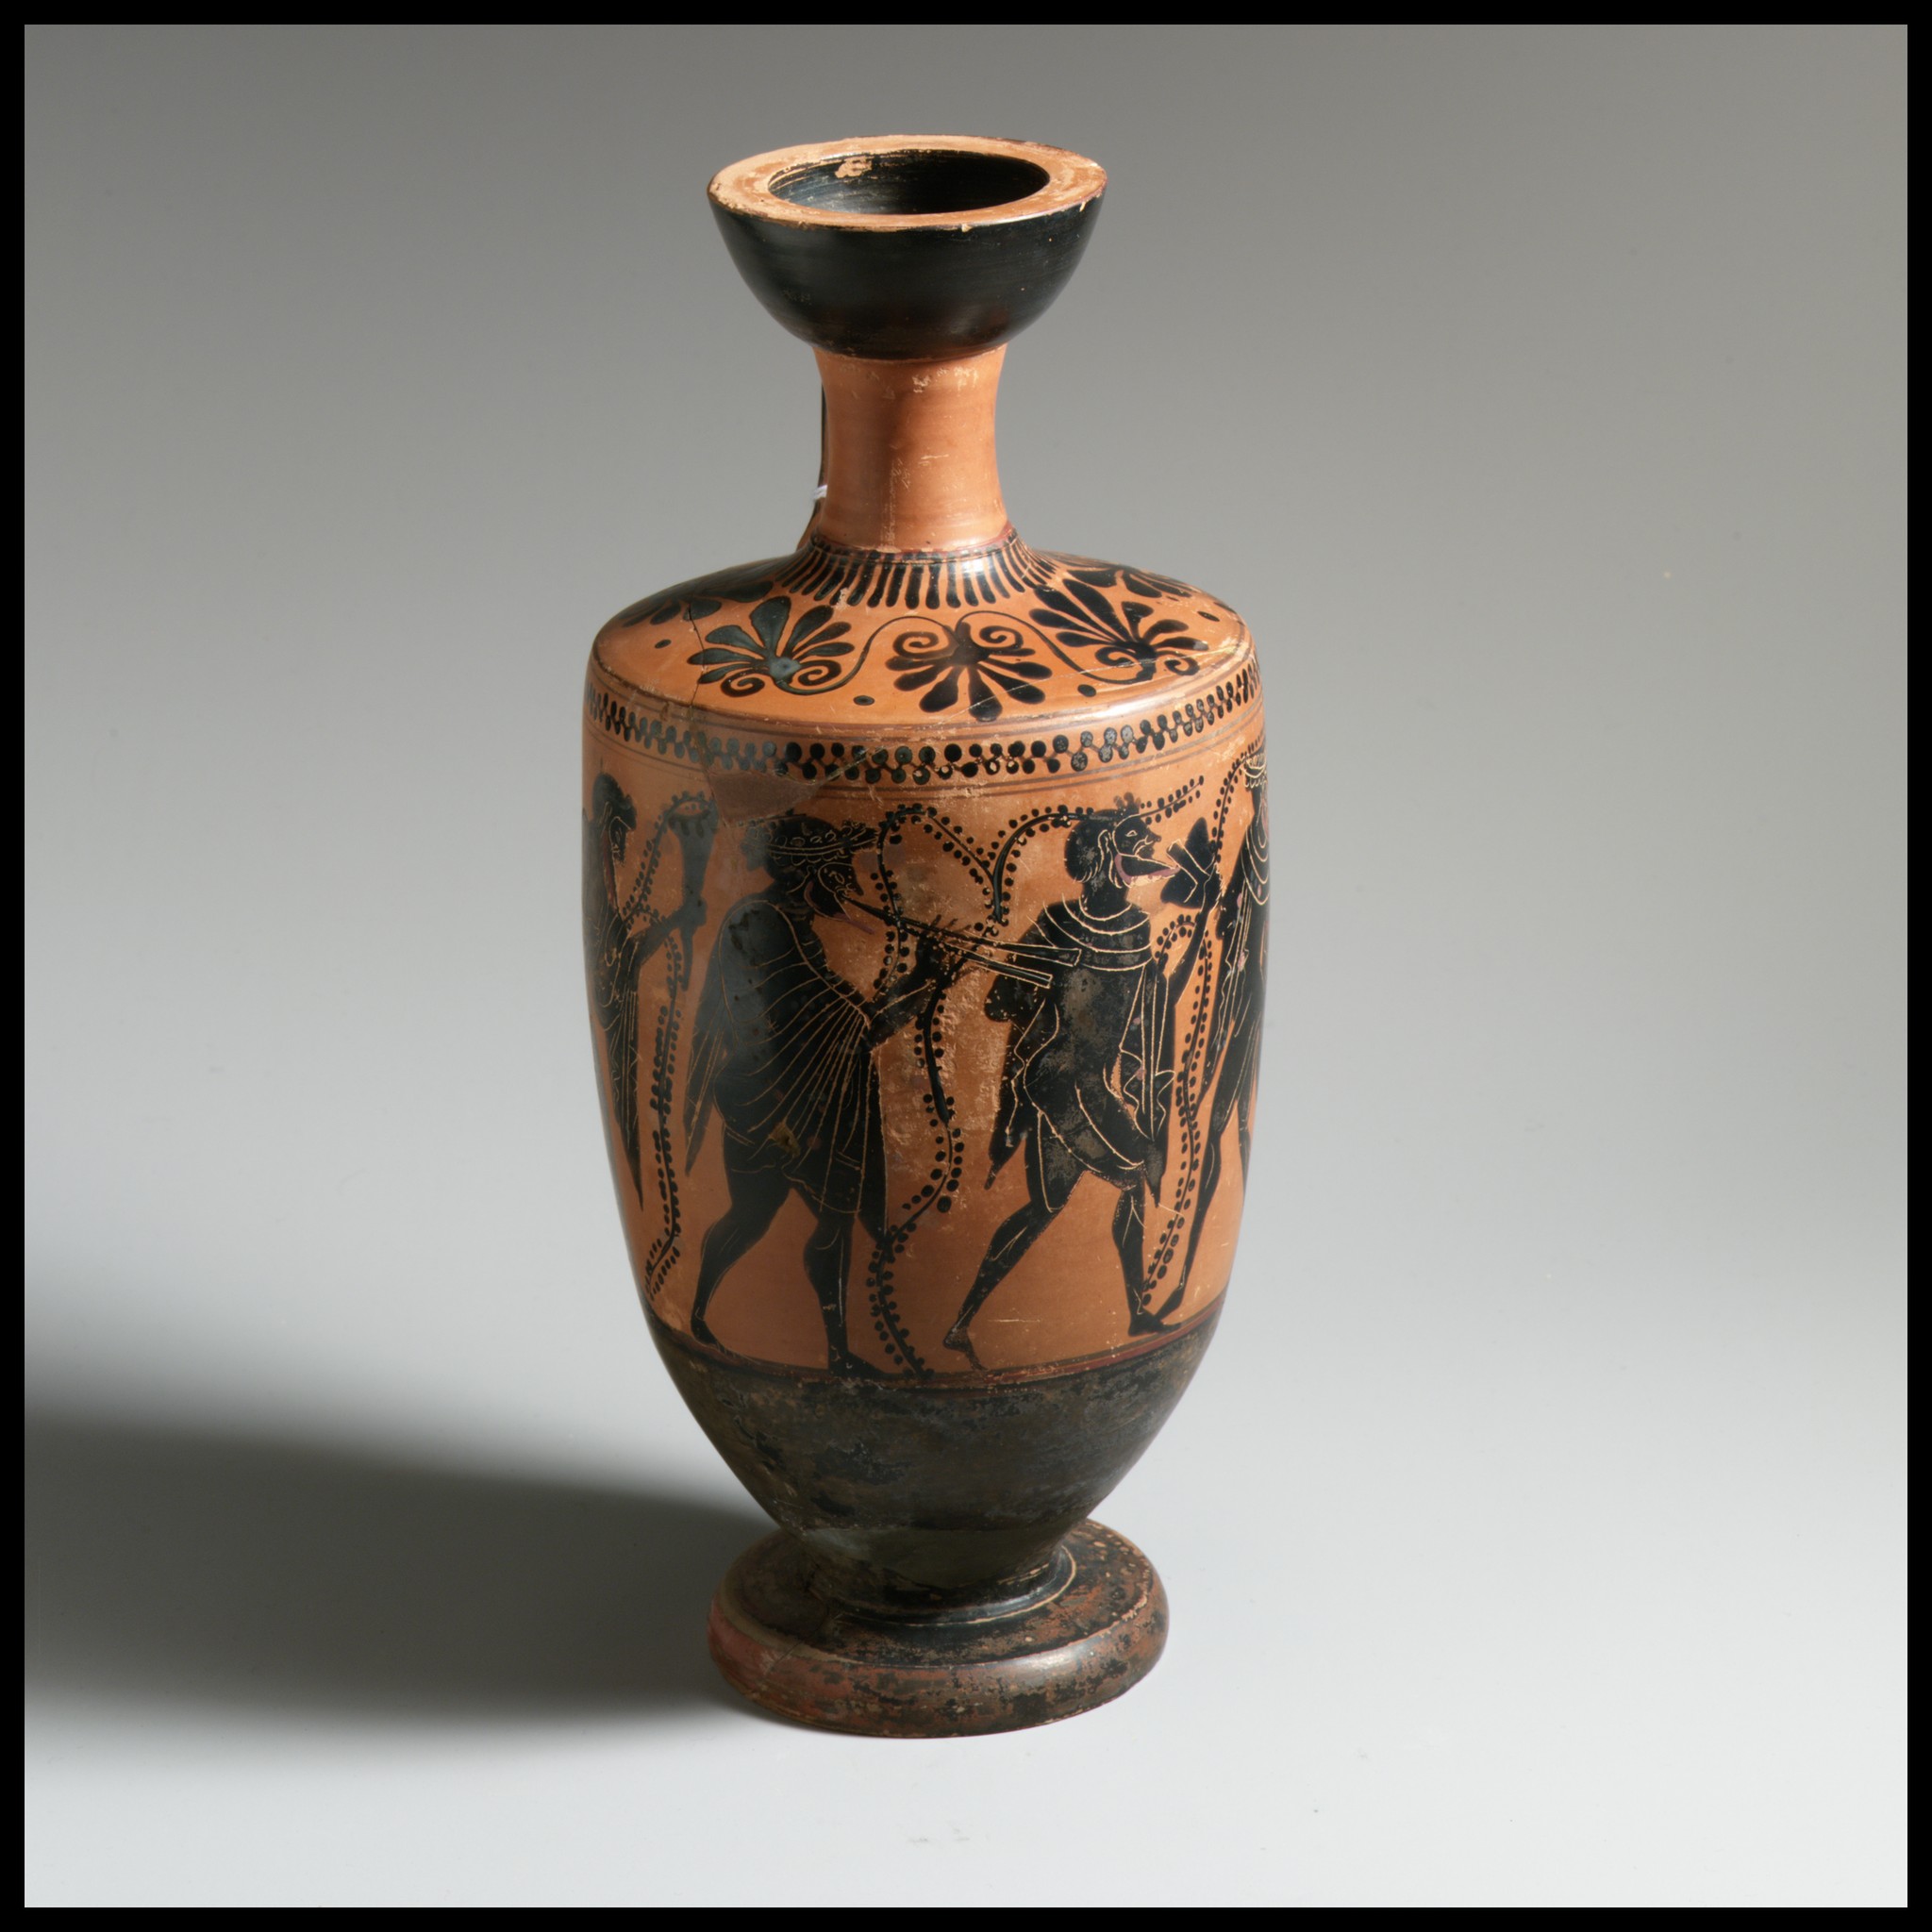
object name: lekythos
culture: greek, attic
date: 600-501 BCE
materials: terracotta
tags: musical instruments,men